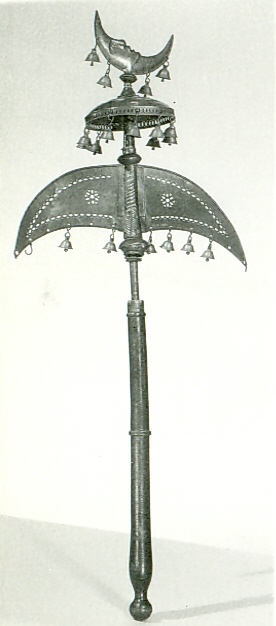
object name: schellenbaum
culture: russian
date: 1751-1800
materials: brass, wood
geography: russia